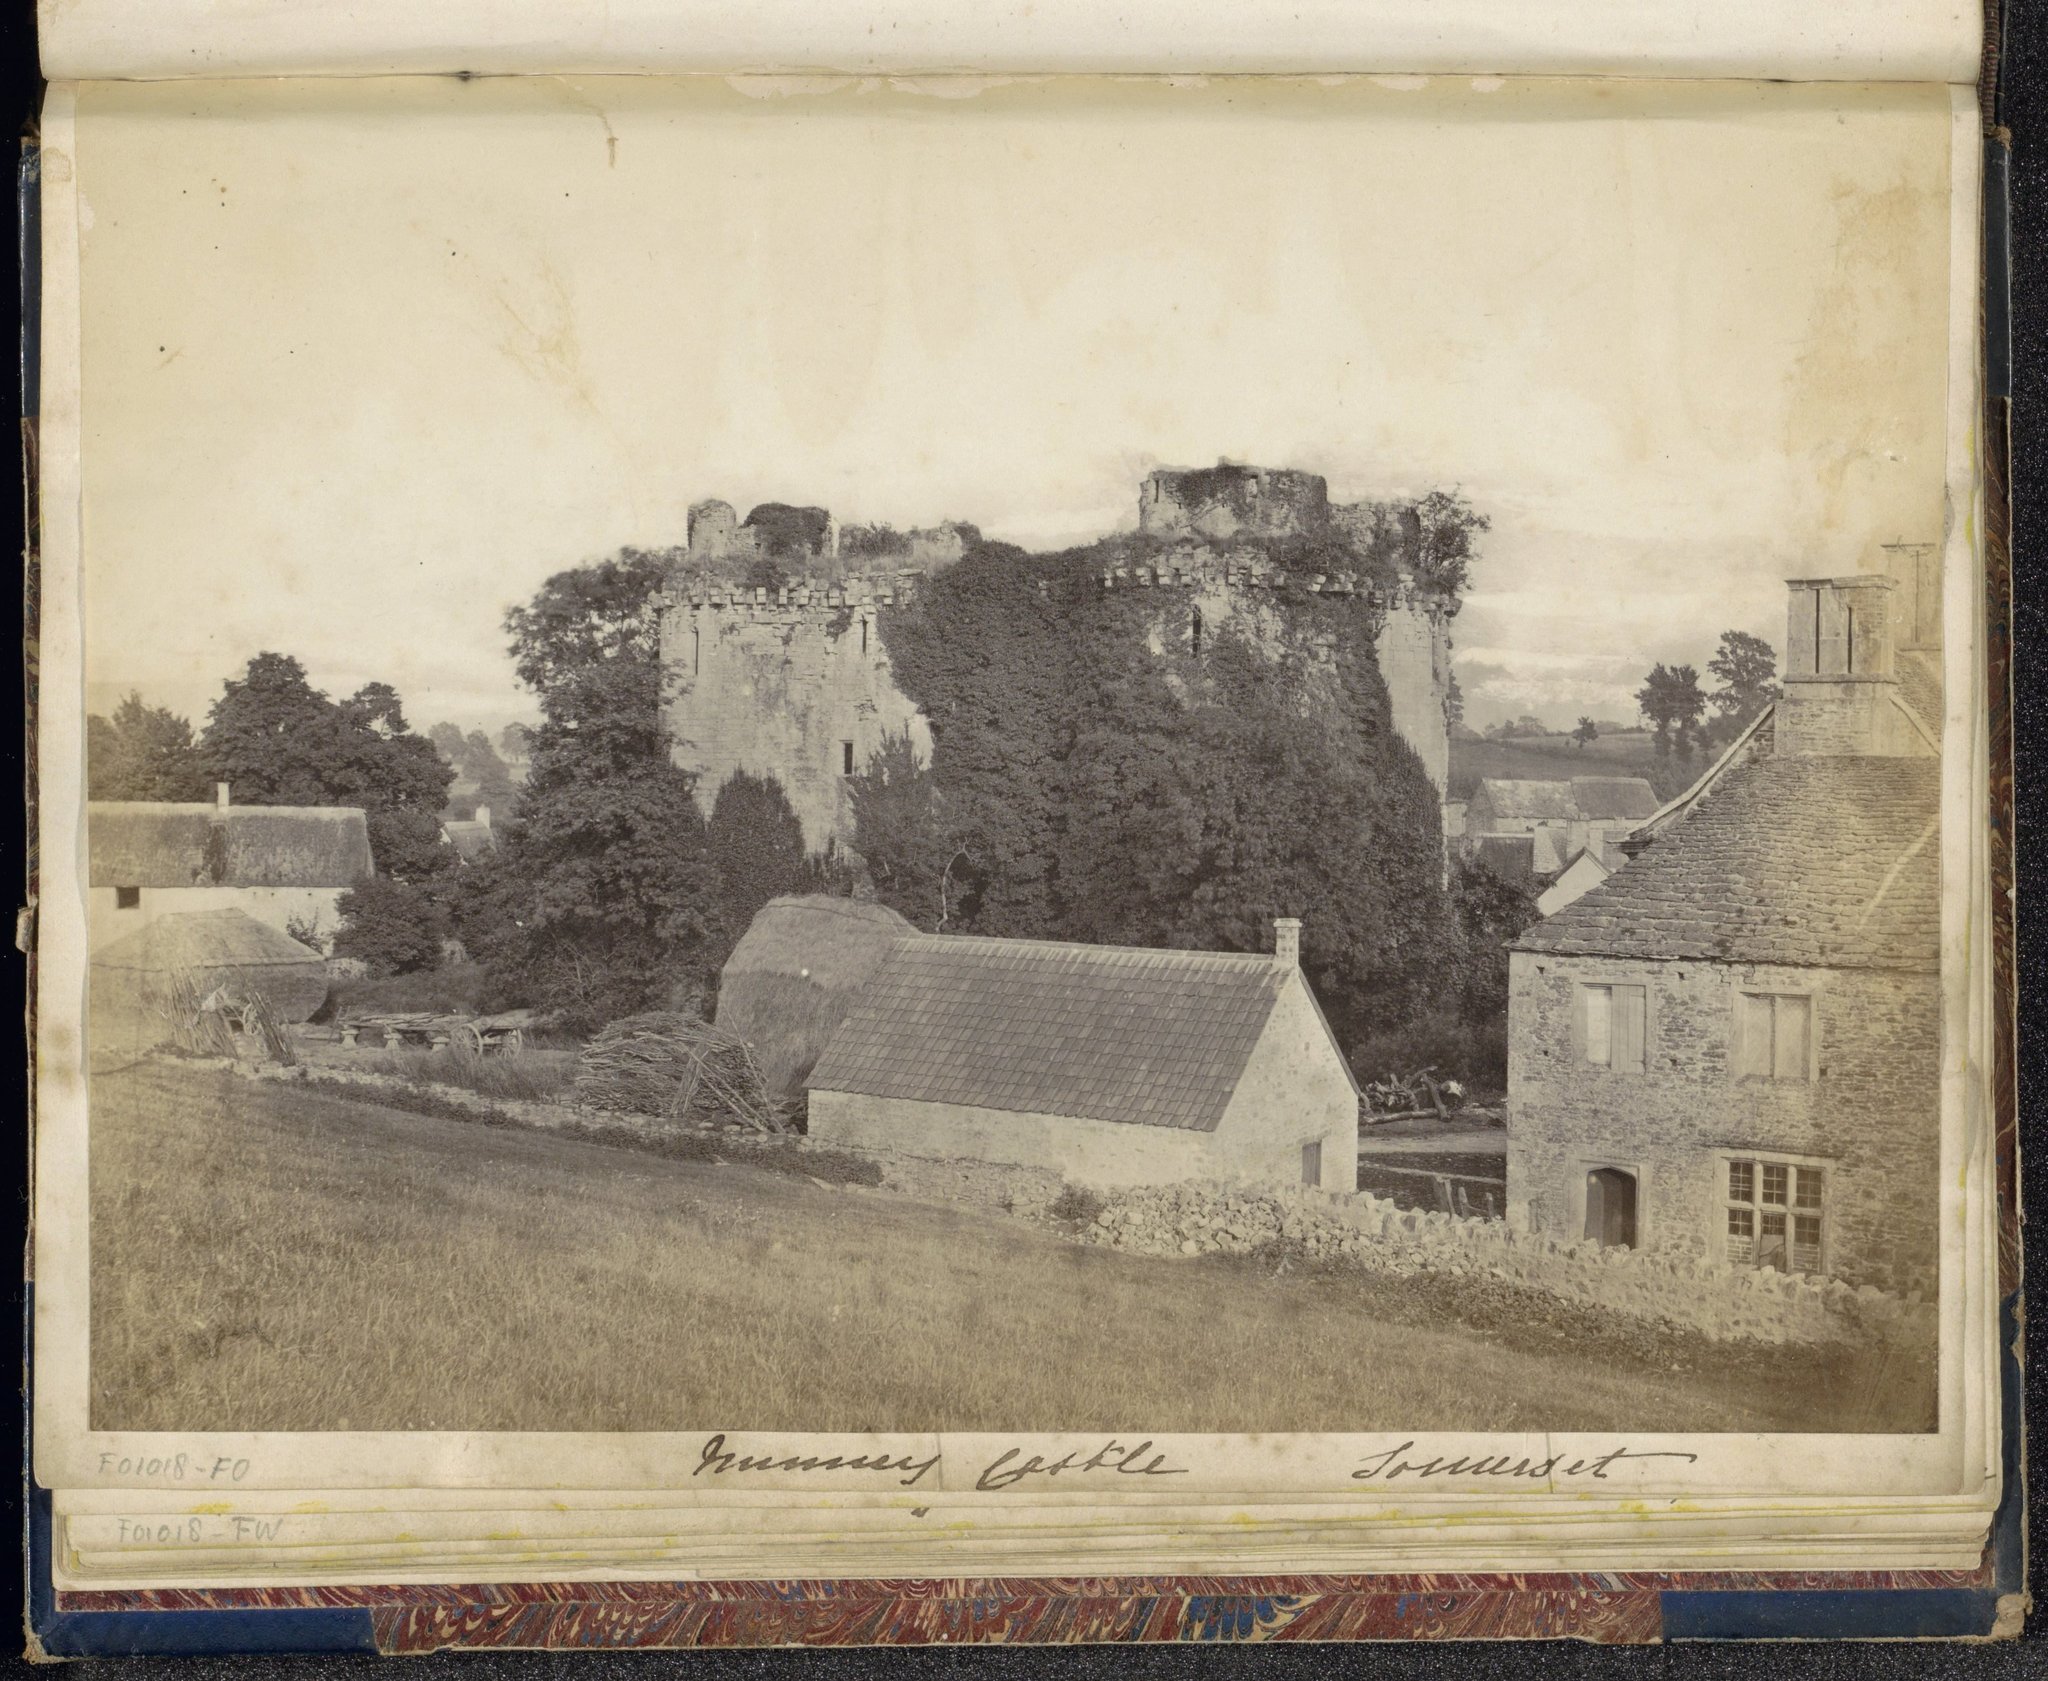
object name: photograph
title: Nunney Castle Somerset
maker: Anonymous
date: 1860-1870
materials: paper, photographic support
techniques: albumen print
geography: nunney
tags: castle, ruin of a dwelling, house, castle, etc., plants and herbs: ivy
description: Onderdeel van Engels familiealbum met foto's van personen, reizen, cricket en kunstwerken.